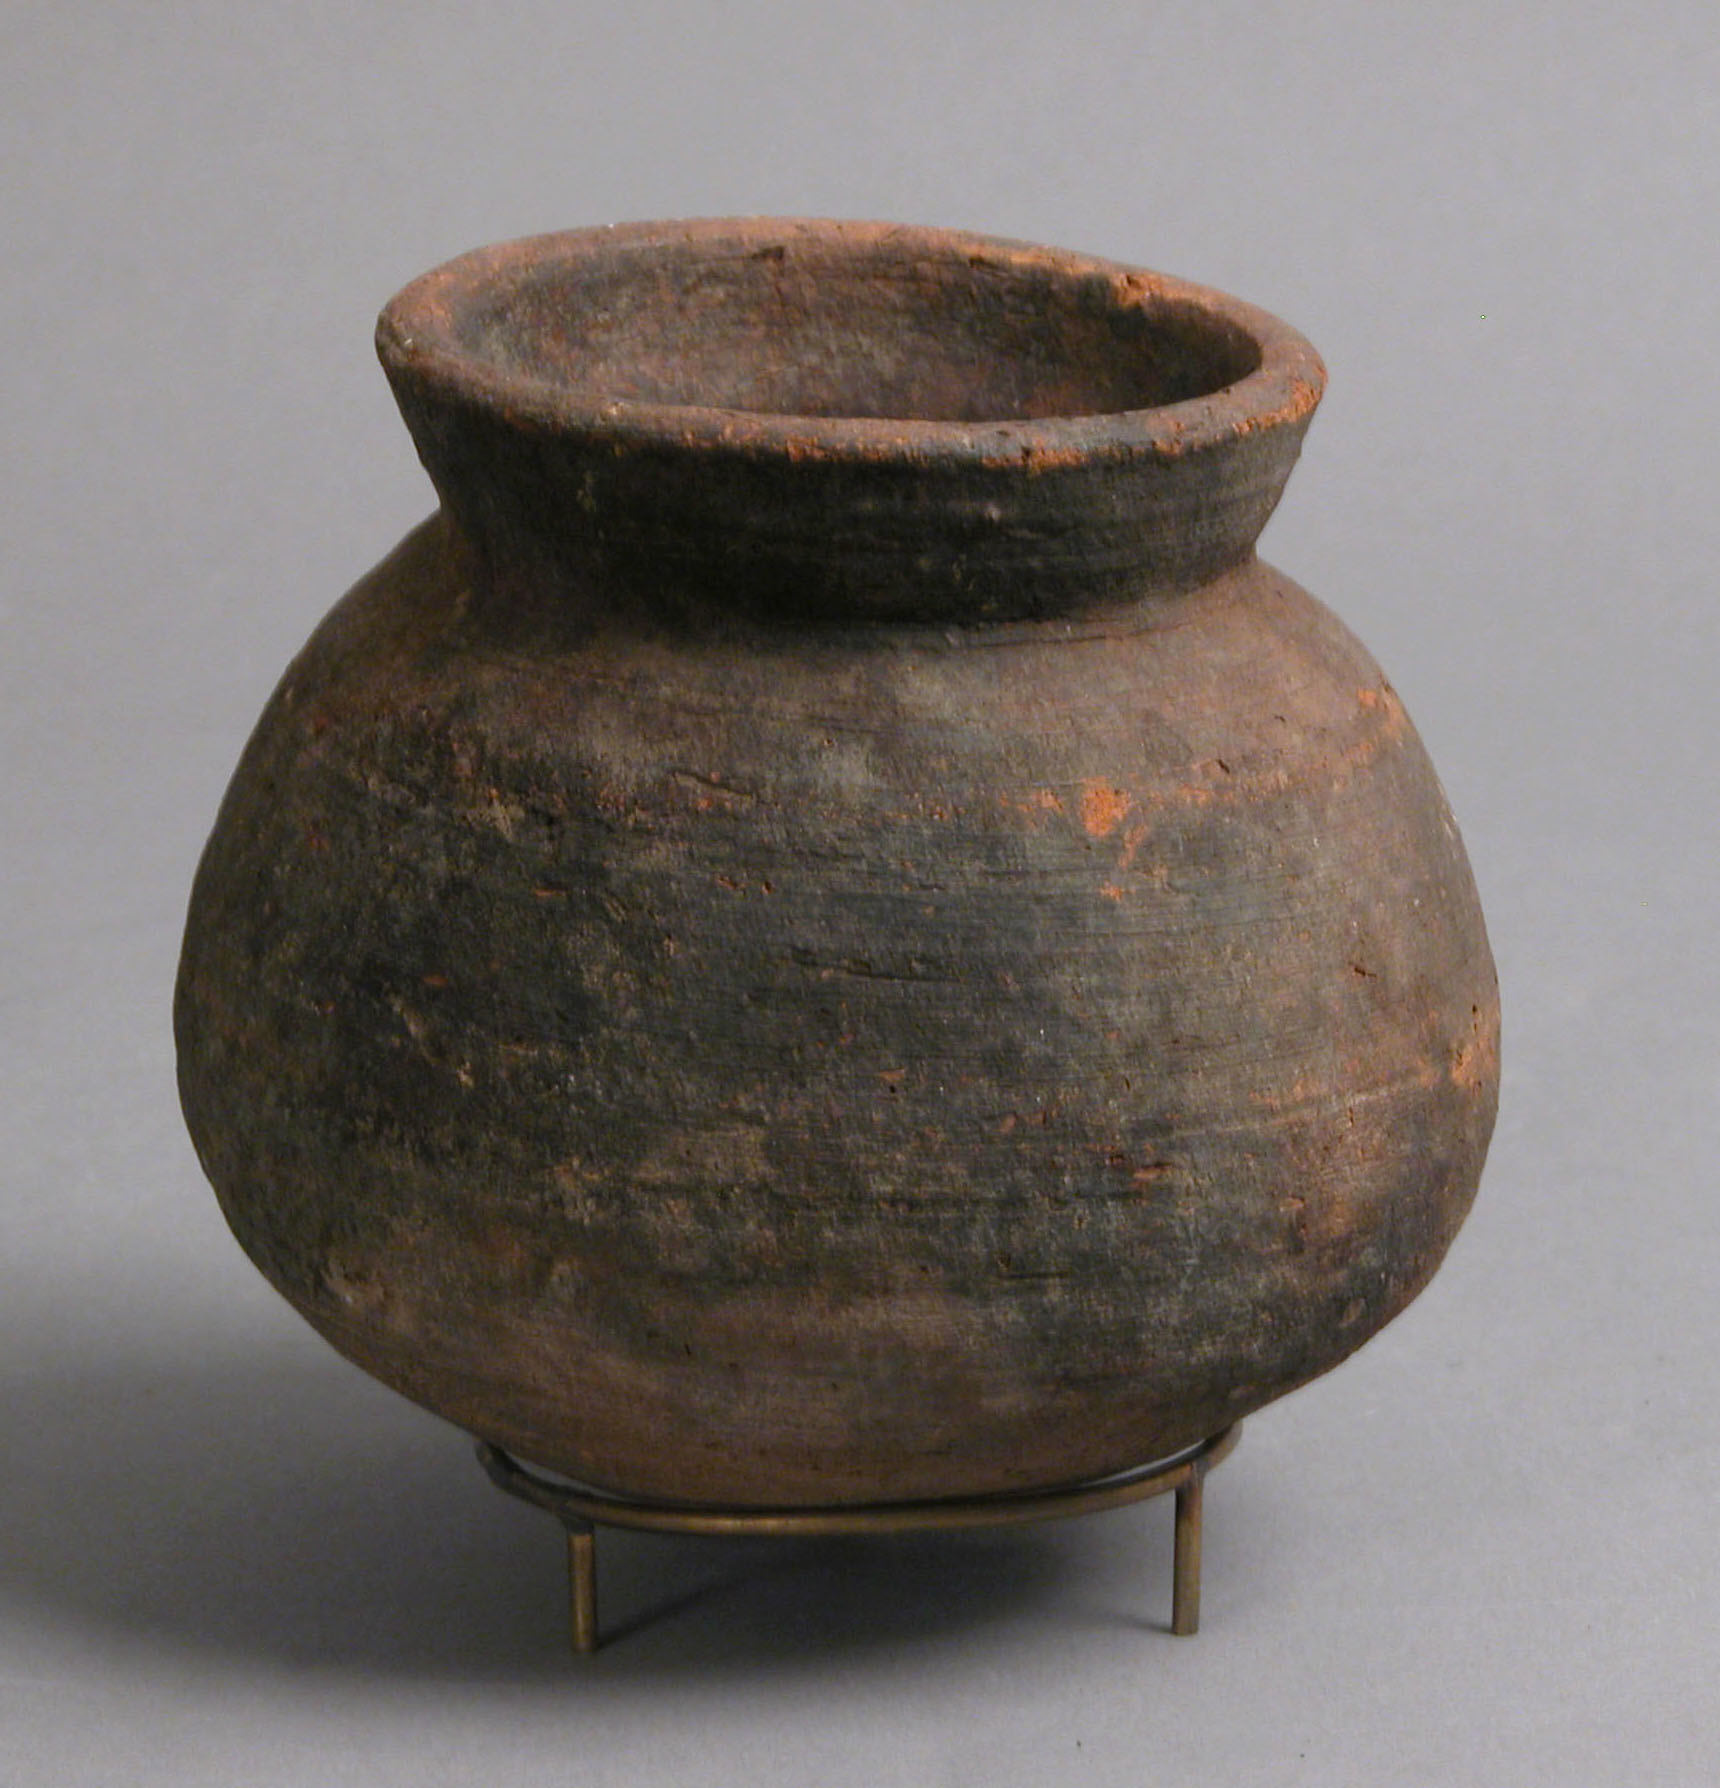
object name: pot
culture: coptic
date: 301-700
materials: earthenware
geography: egypt